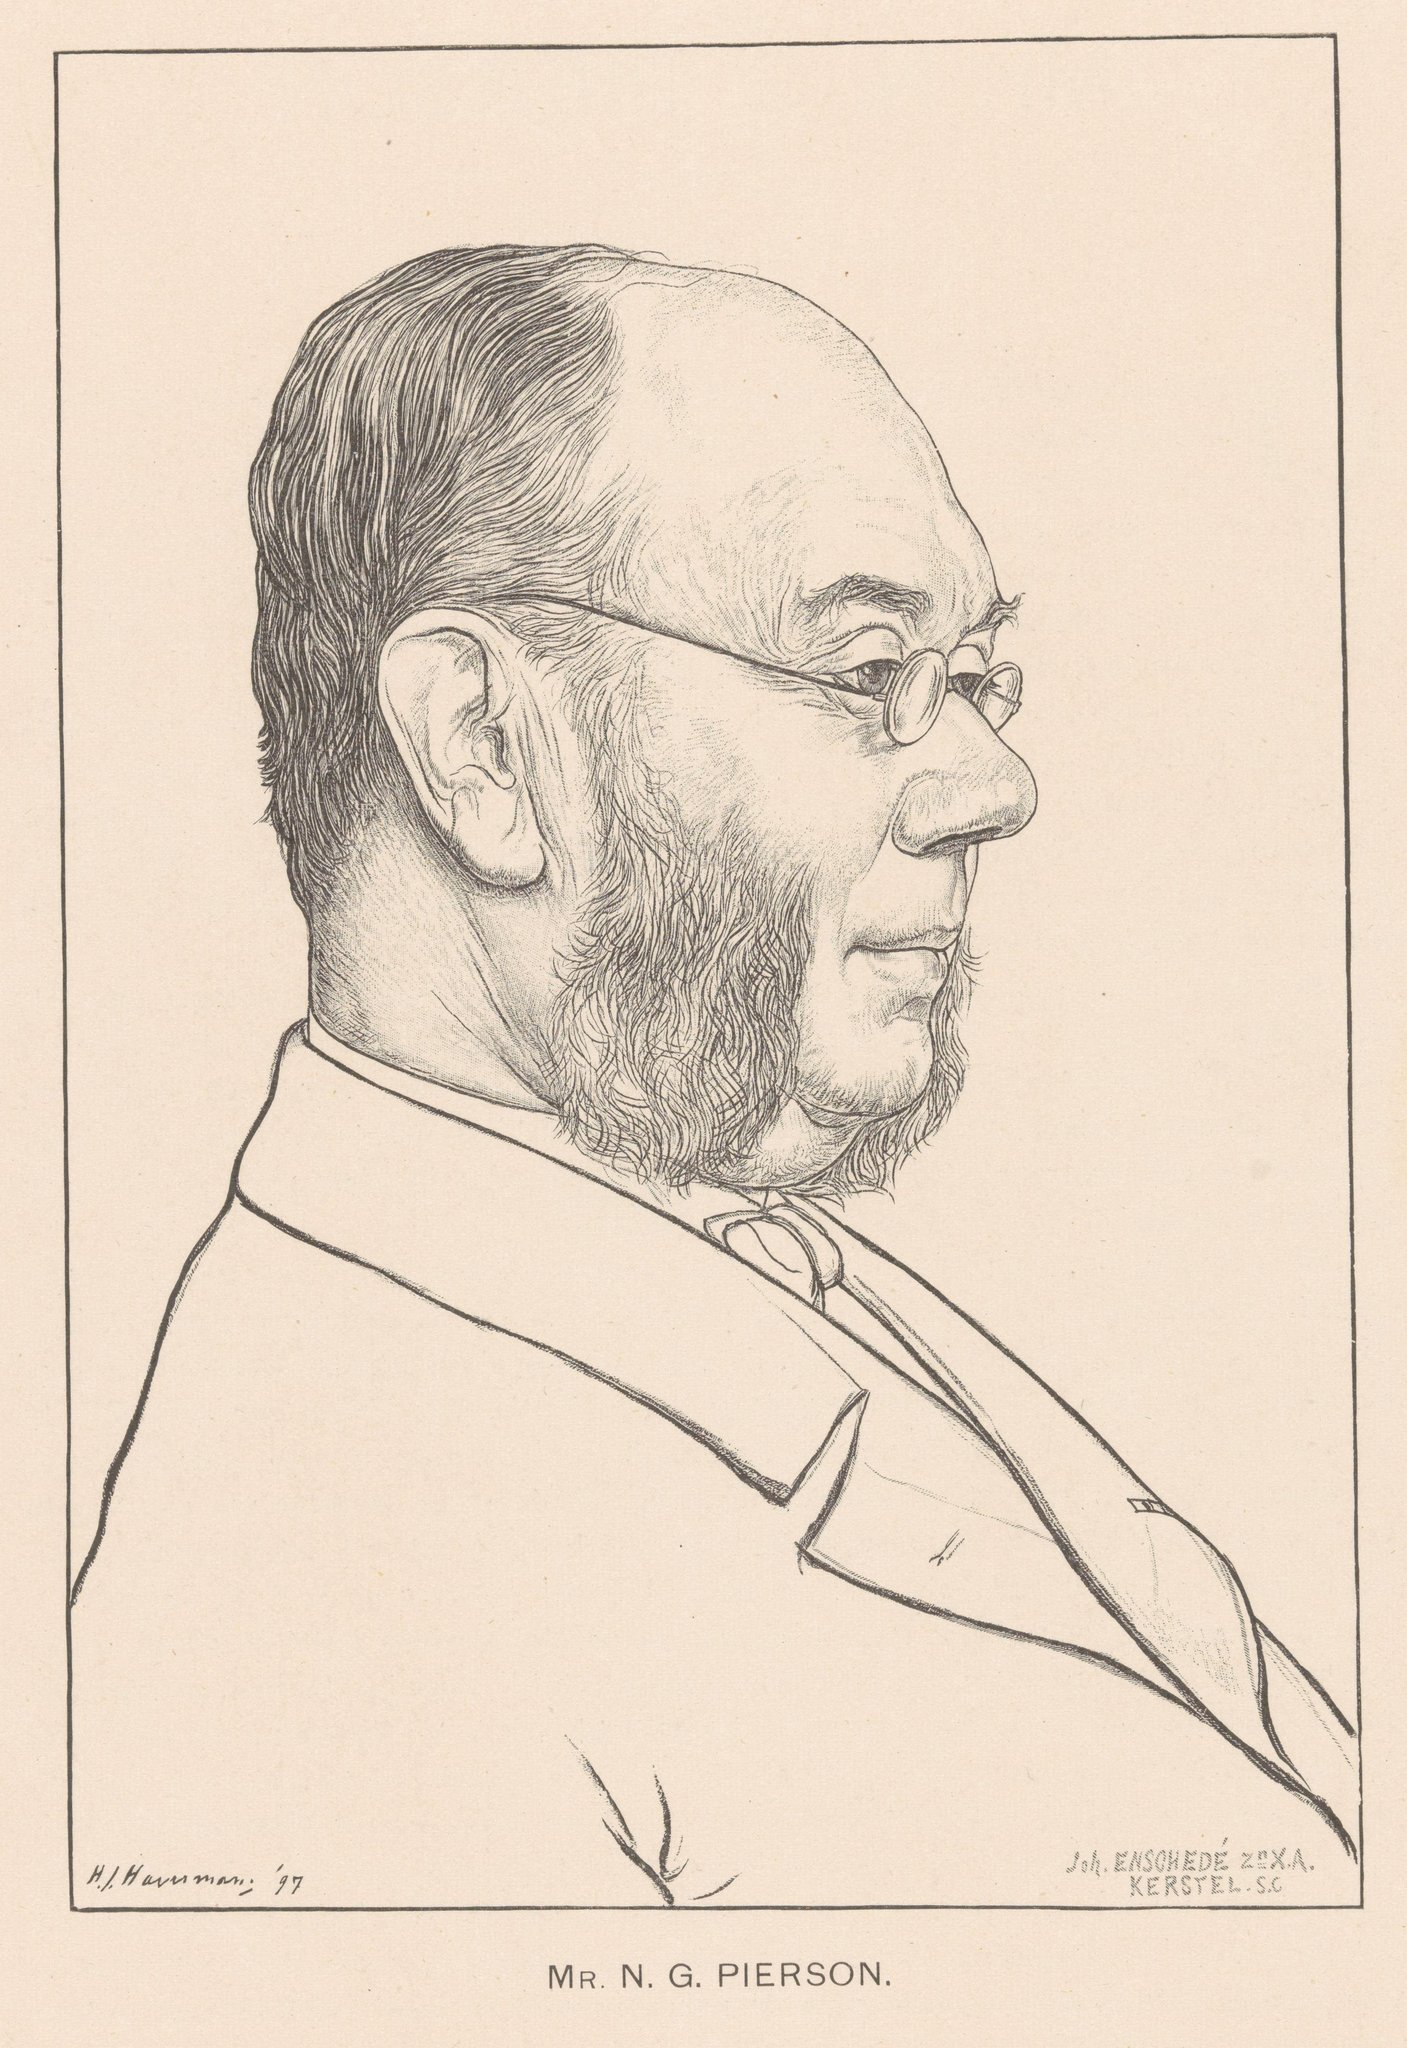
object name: print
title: Portret van Nicolaas Gerard Pierson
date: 1897-1935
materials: paper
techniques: lithograph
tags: amsterdam, nicolaas gerard pierson, sideburns, historical persons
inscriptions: collector's mark: Lugt 2228, collector's mark: Lugt 2760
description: Een portret van bankier, minister en premier Nicolaas Gerard Pierson, met bakkebaarden en bril.